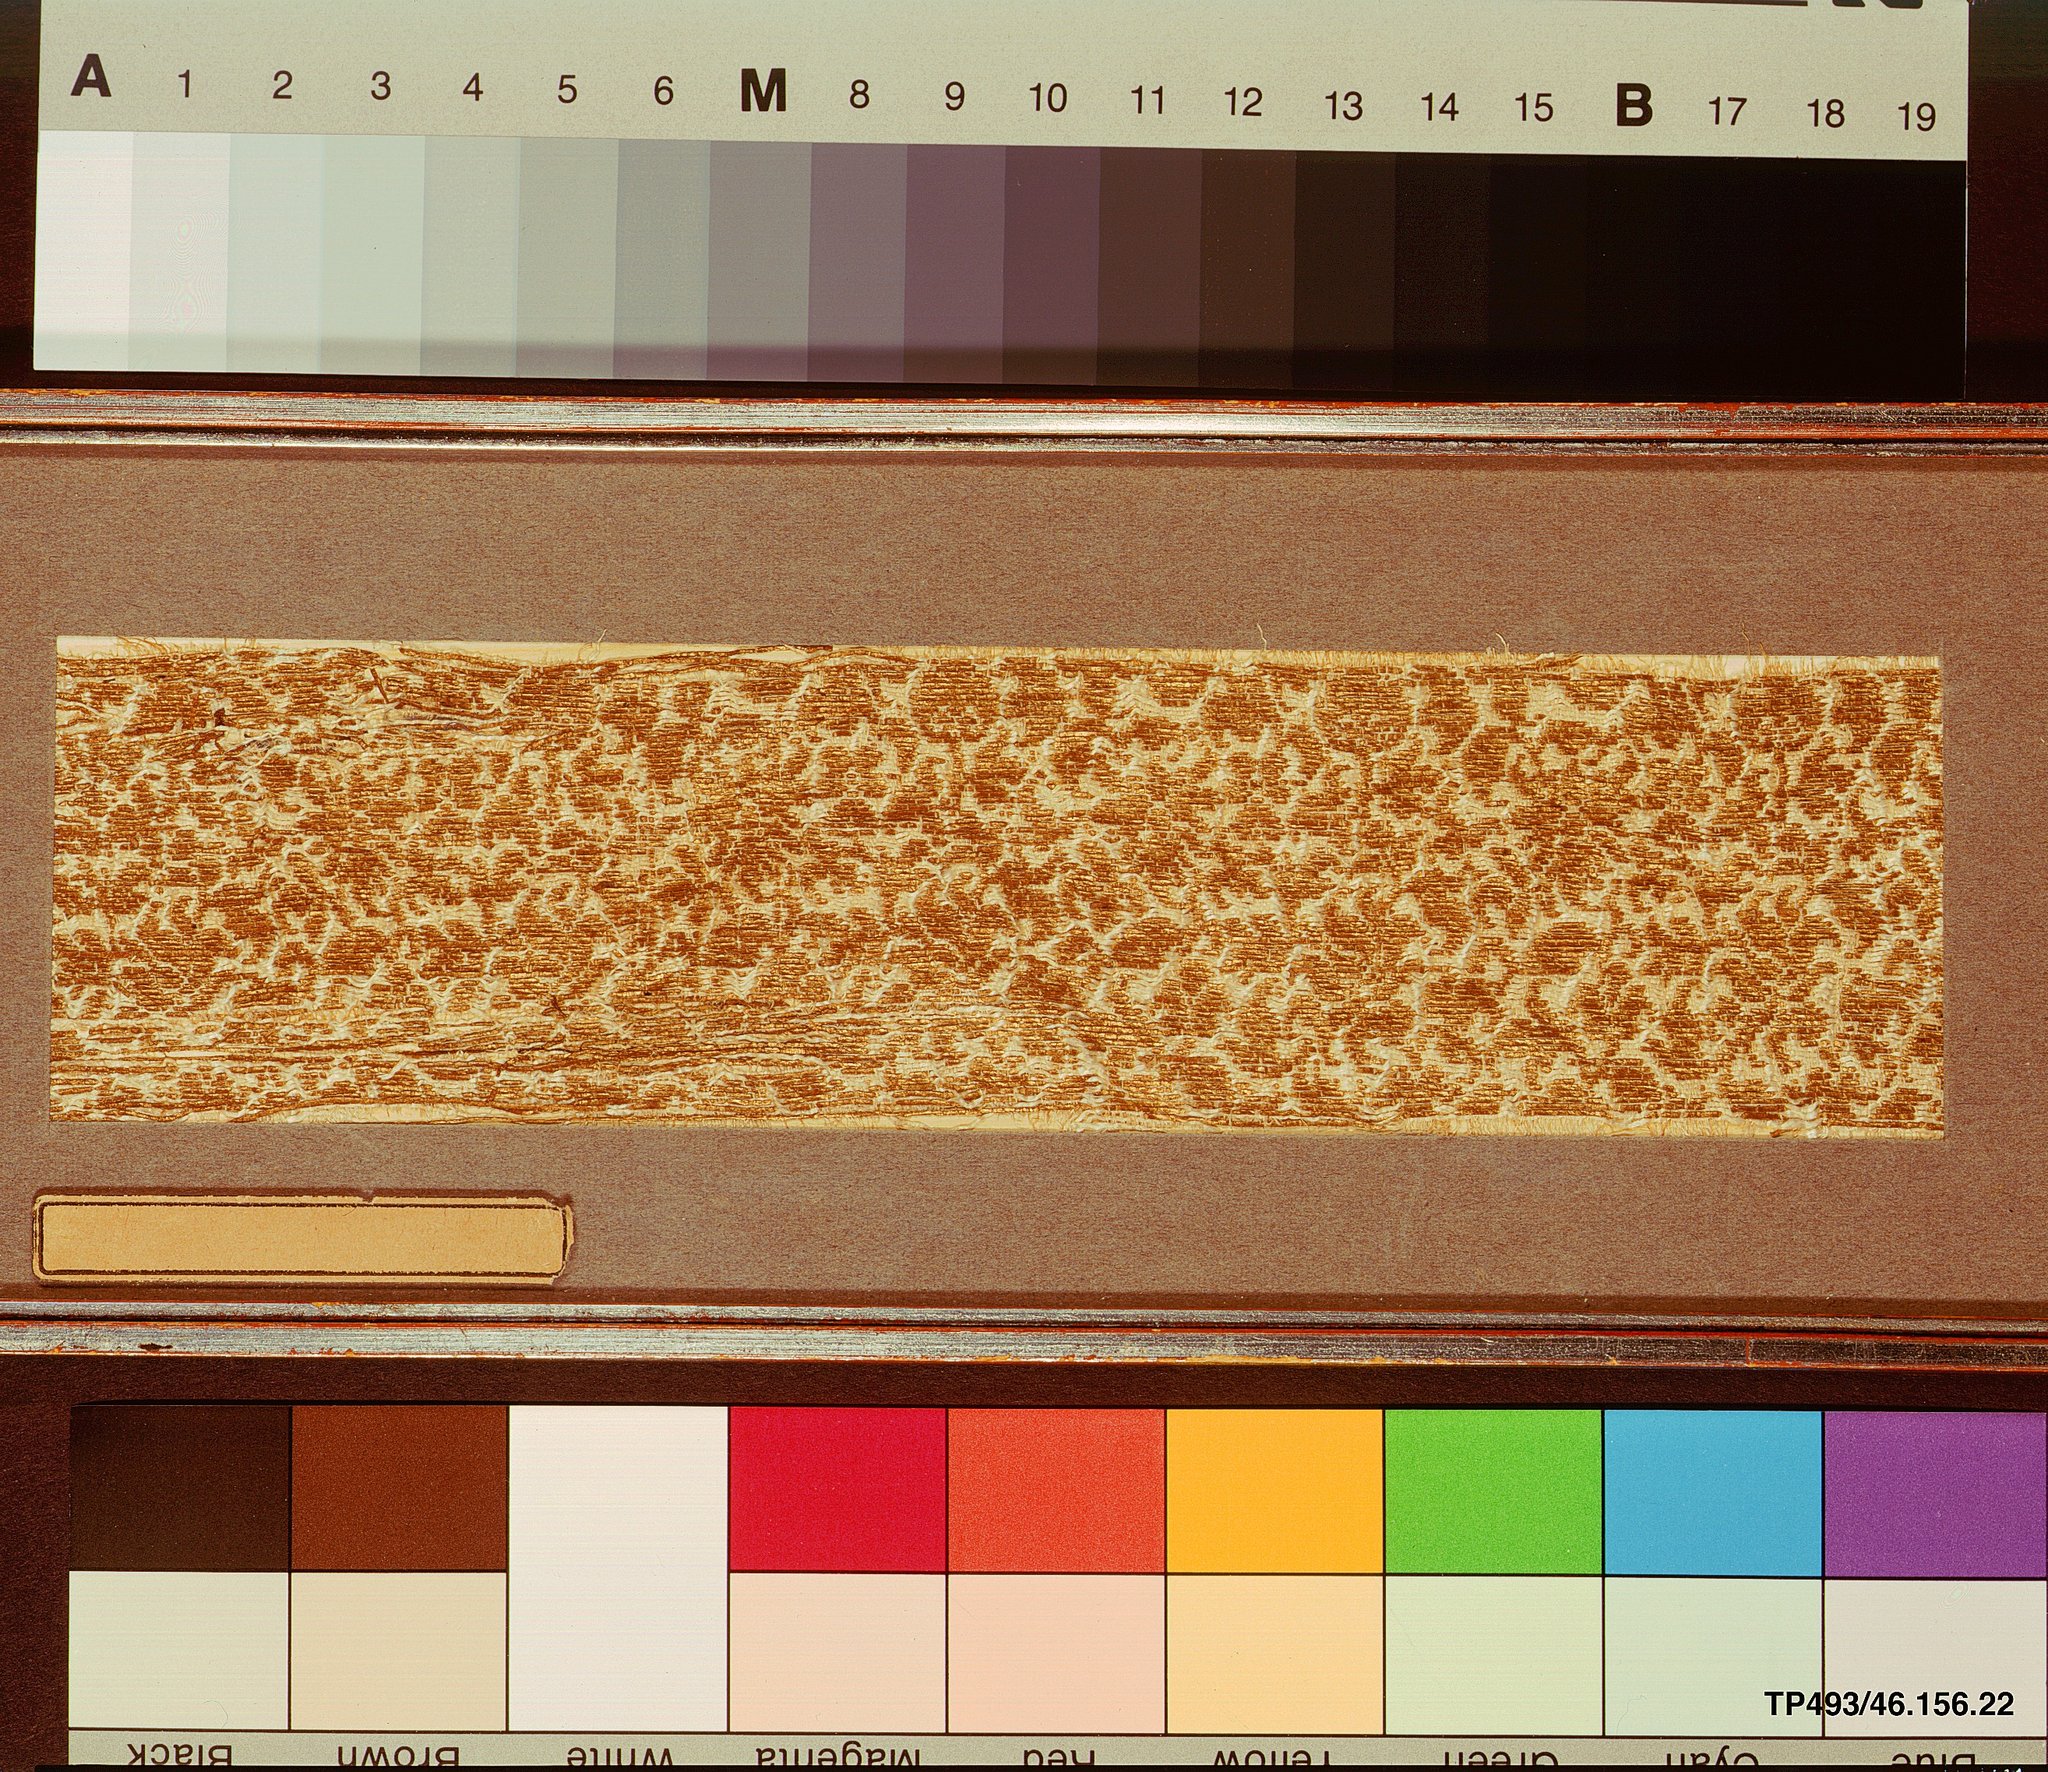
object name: textile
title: Woven Textile with Small Scale Floral Pattern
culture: central asian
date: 1267-1366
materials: metal thread, silk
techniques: lampas, weave